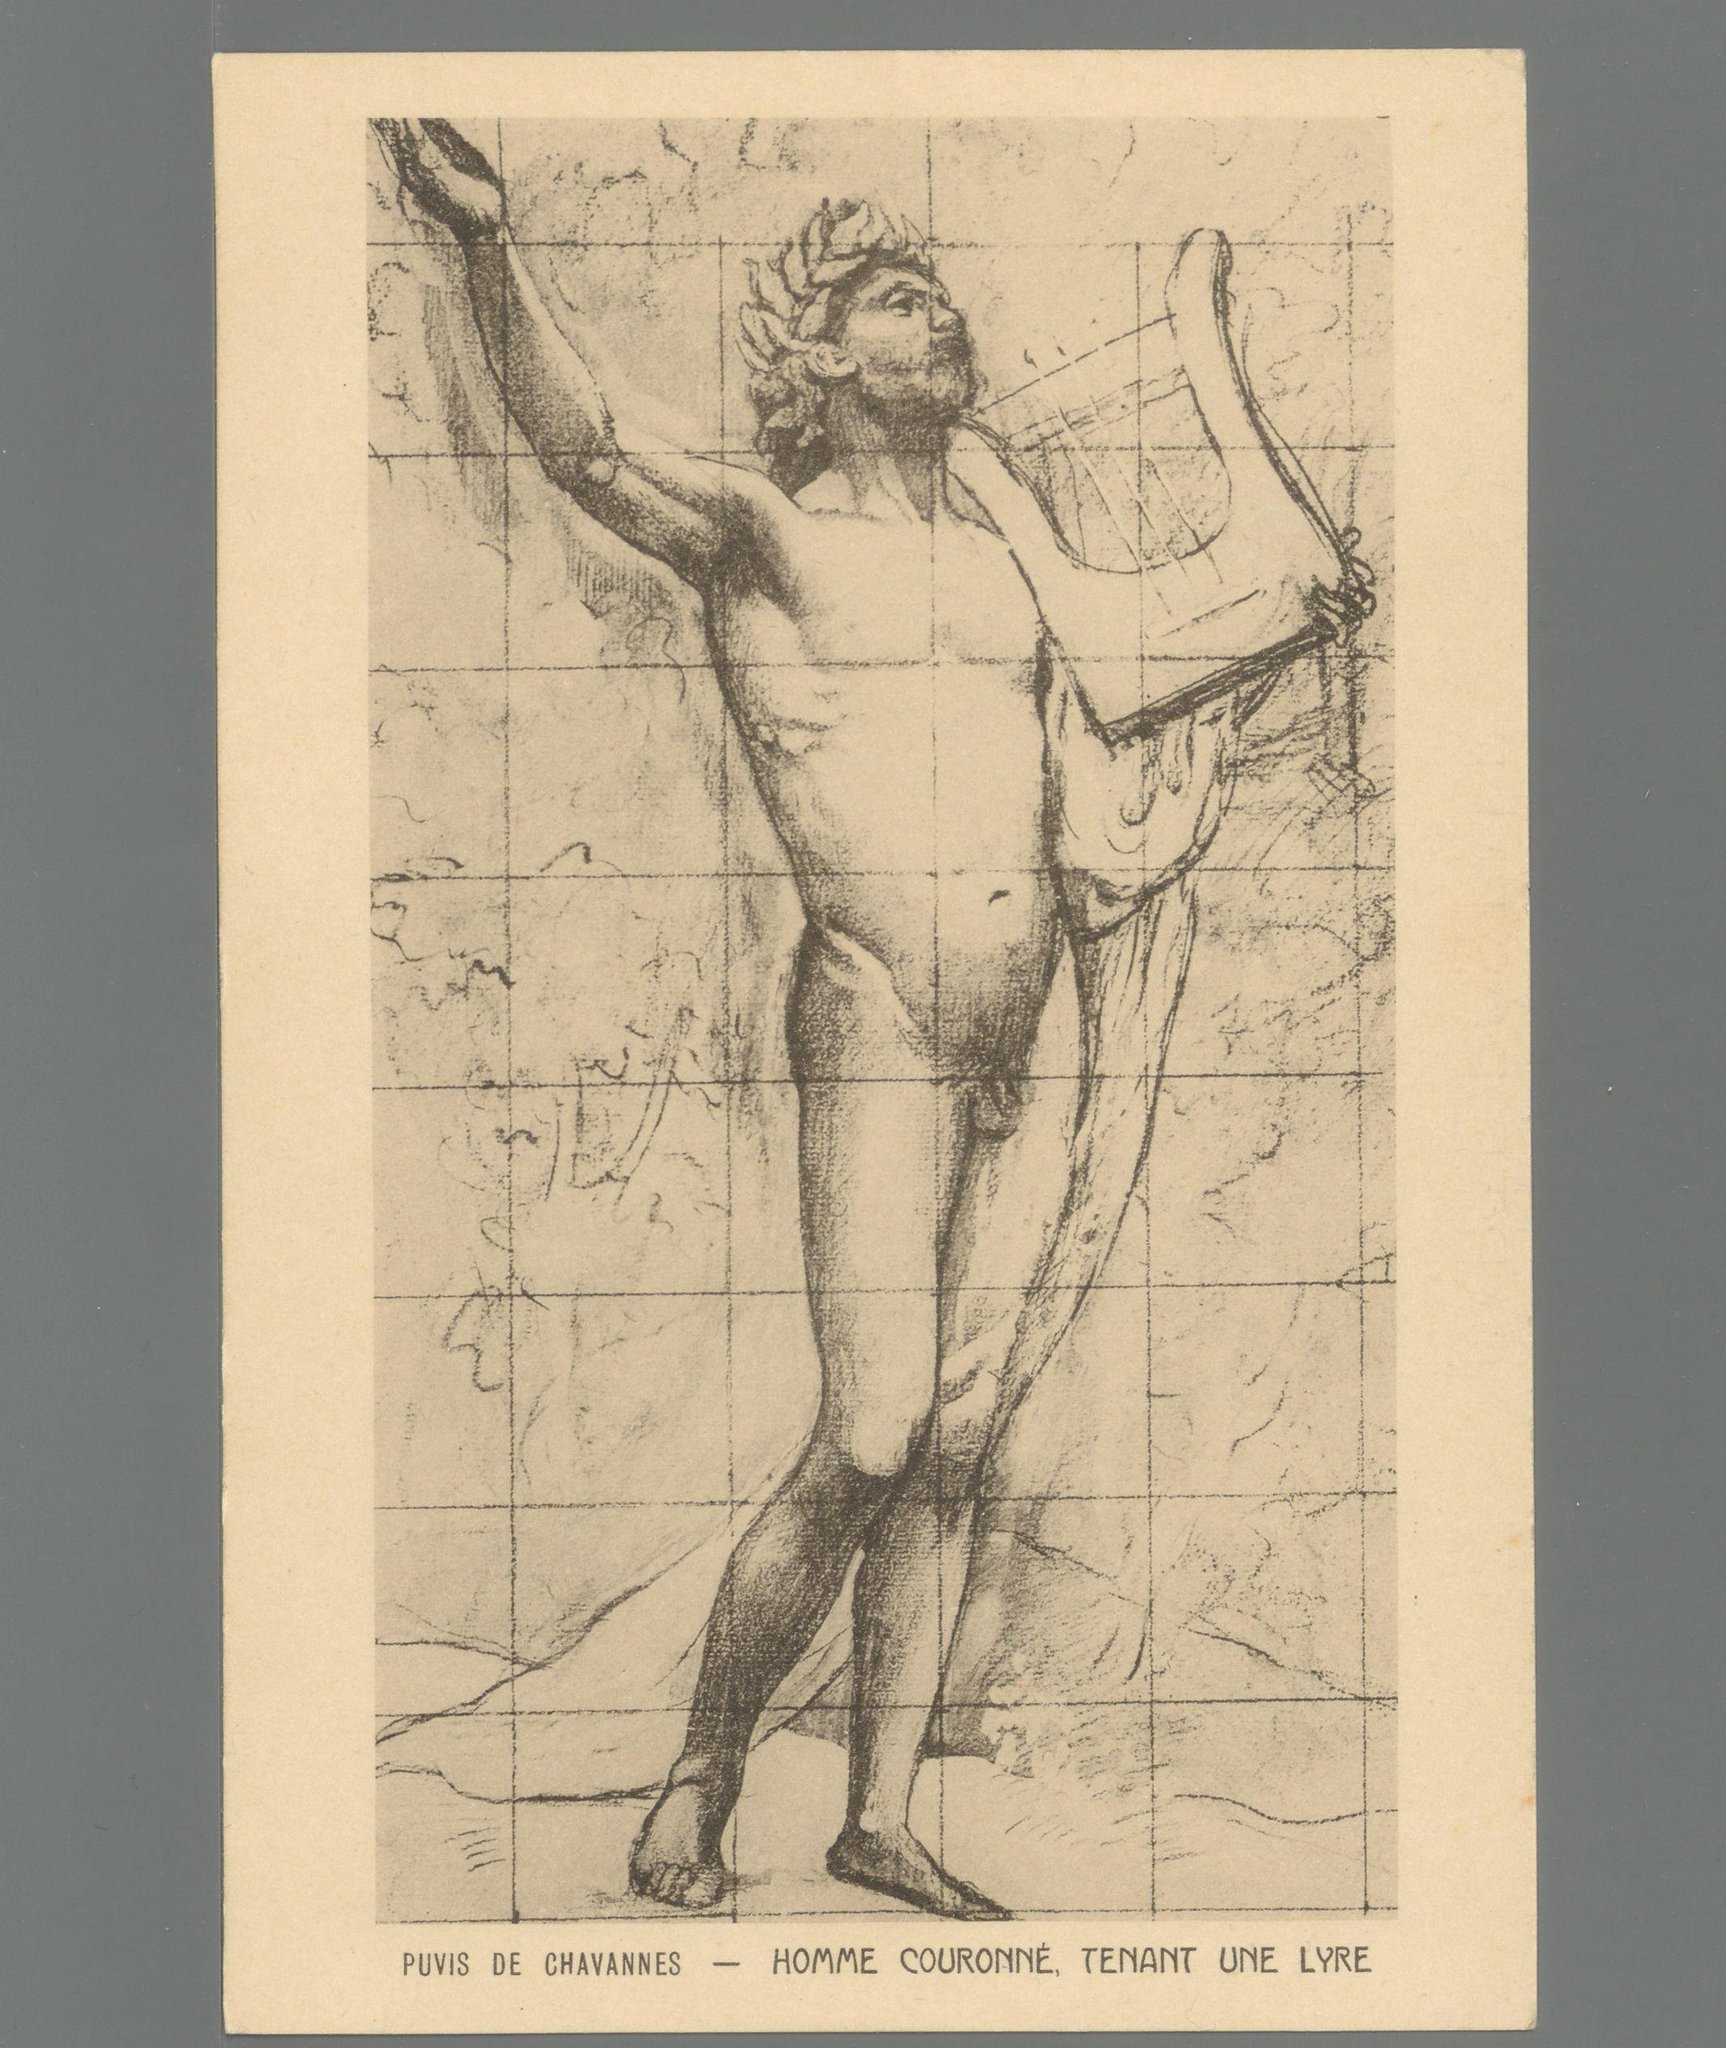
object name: ansichtkaart, prentbriefkaart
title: Puvis de Chavannes - Homme couronné, tentant une lyre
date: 1903-1930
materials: cardboard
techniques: photograph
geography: paris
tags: drawing, sketch, permanent exhibition, museum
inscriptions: collector's mark: ‘AFE v S’